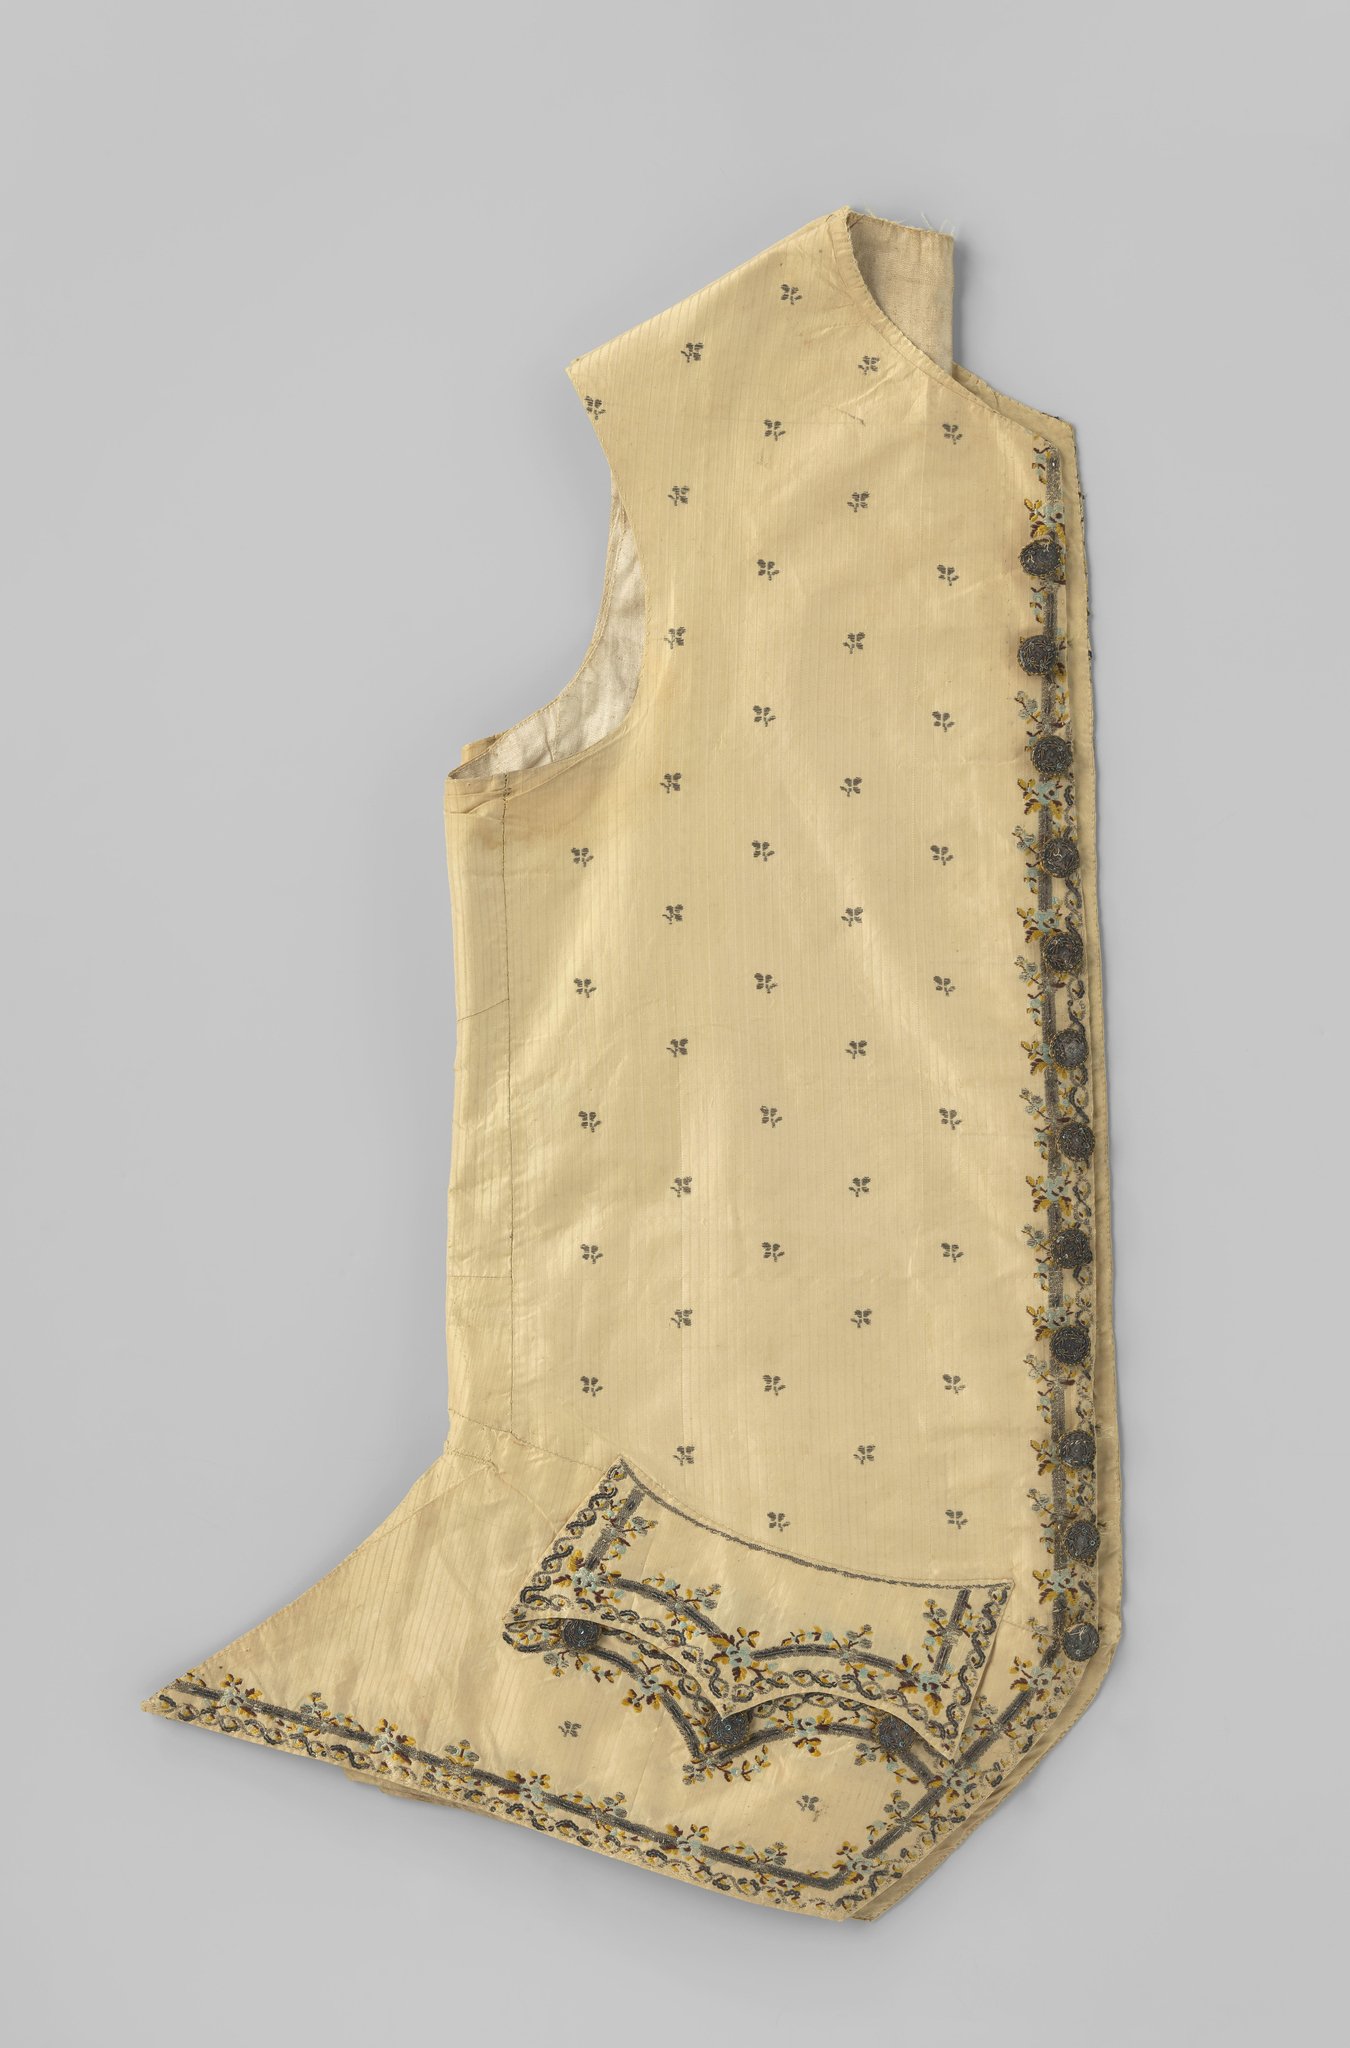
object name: main garment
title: Lang mouwloos vest van citroengeel gestreepte zijde, met geborduurde bloemen van zilverdraad, blauwe en gele zijde en pailletten; 12 knopen van metaaldraad en pailletten.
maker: Anonymous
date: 1770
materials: metal thread, silk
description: Vest van citroengeel gestreept zijde, met bloemen van zilverdraad, blauwe en gele zijde en pailletten. Knopen op dezelfde wijze overtrokken. Geen kraag, gespleten rug.